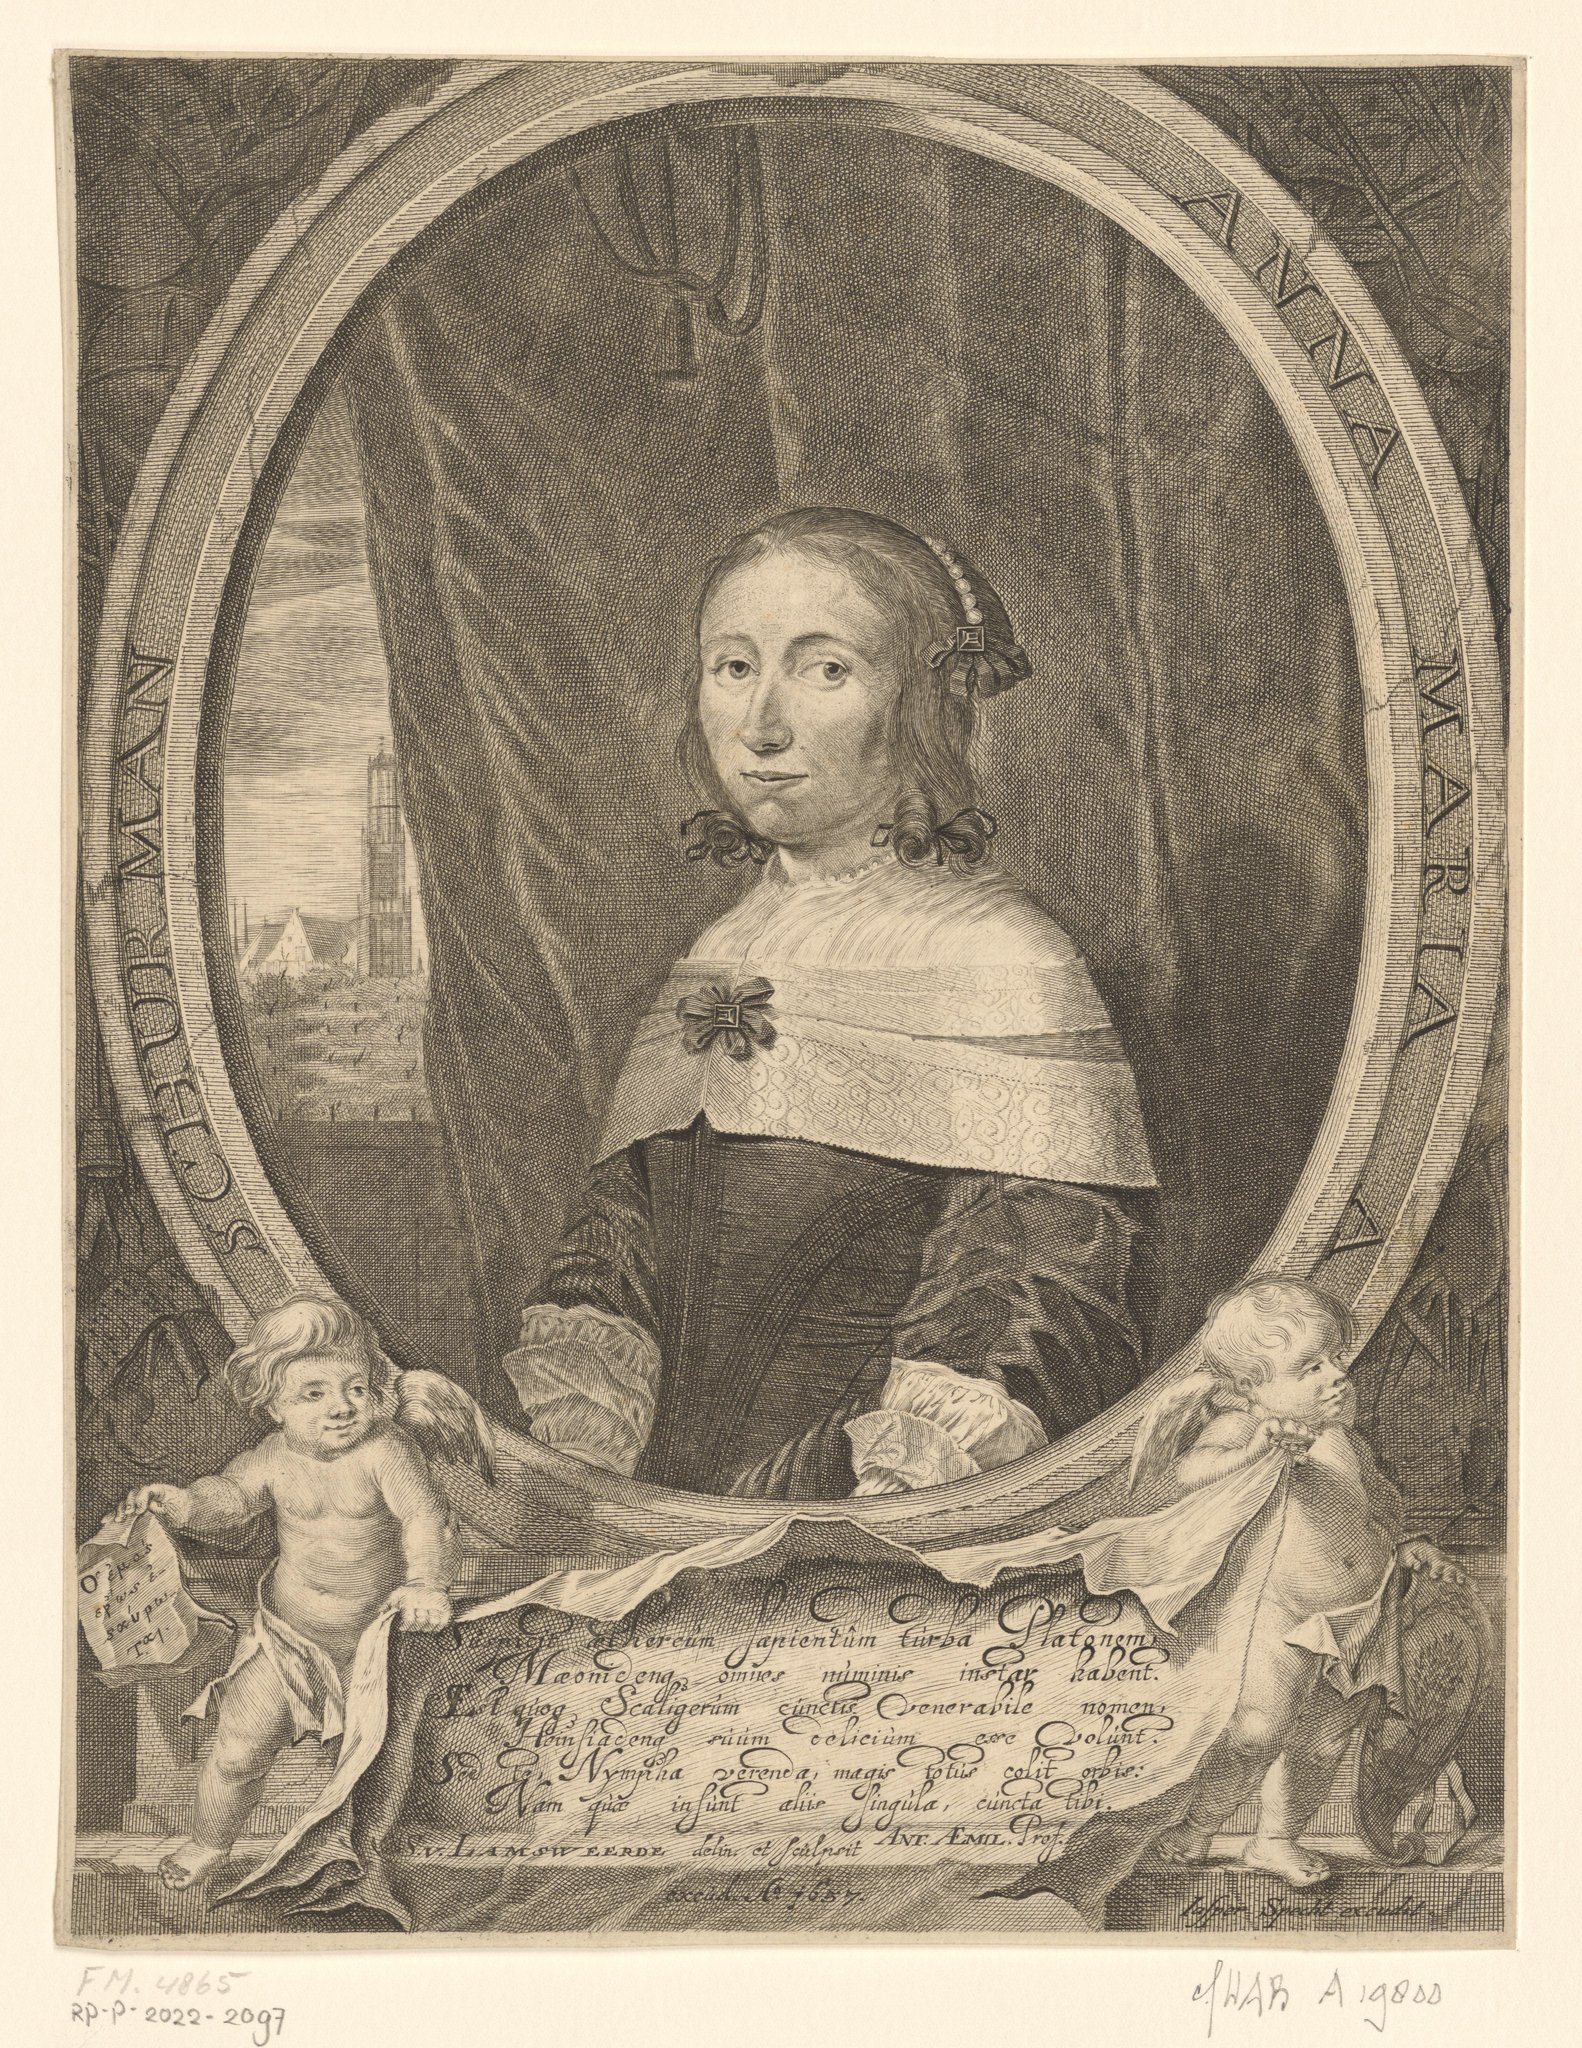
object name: print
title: Portret van Anna Maria van Schurman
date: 1657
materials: paper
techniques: engraving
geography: utrecht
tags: cologne, print maker, draughtsman, anna maria van schurman, historical persons - bb - woman, portrait, self-portrait of artist, writer, poet, author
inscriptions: collector's mark: Lugt 2760, collector's mark: Lugt 2166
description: Met zesregelig onderschrift in het Latijn.